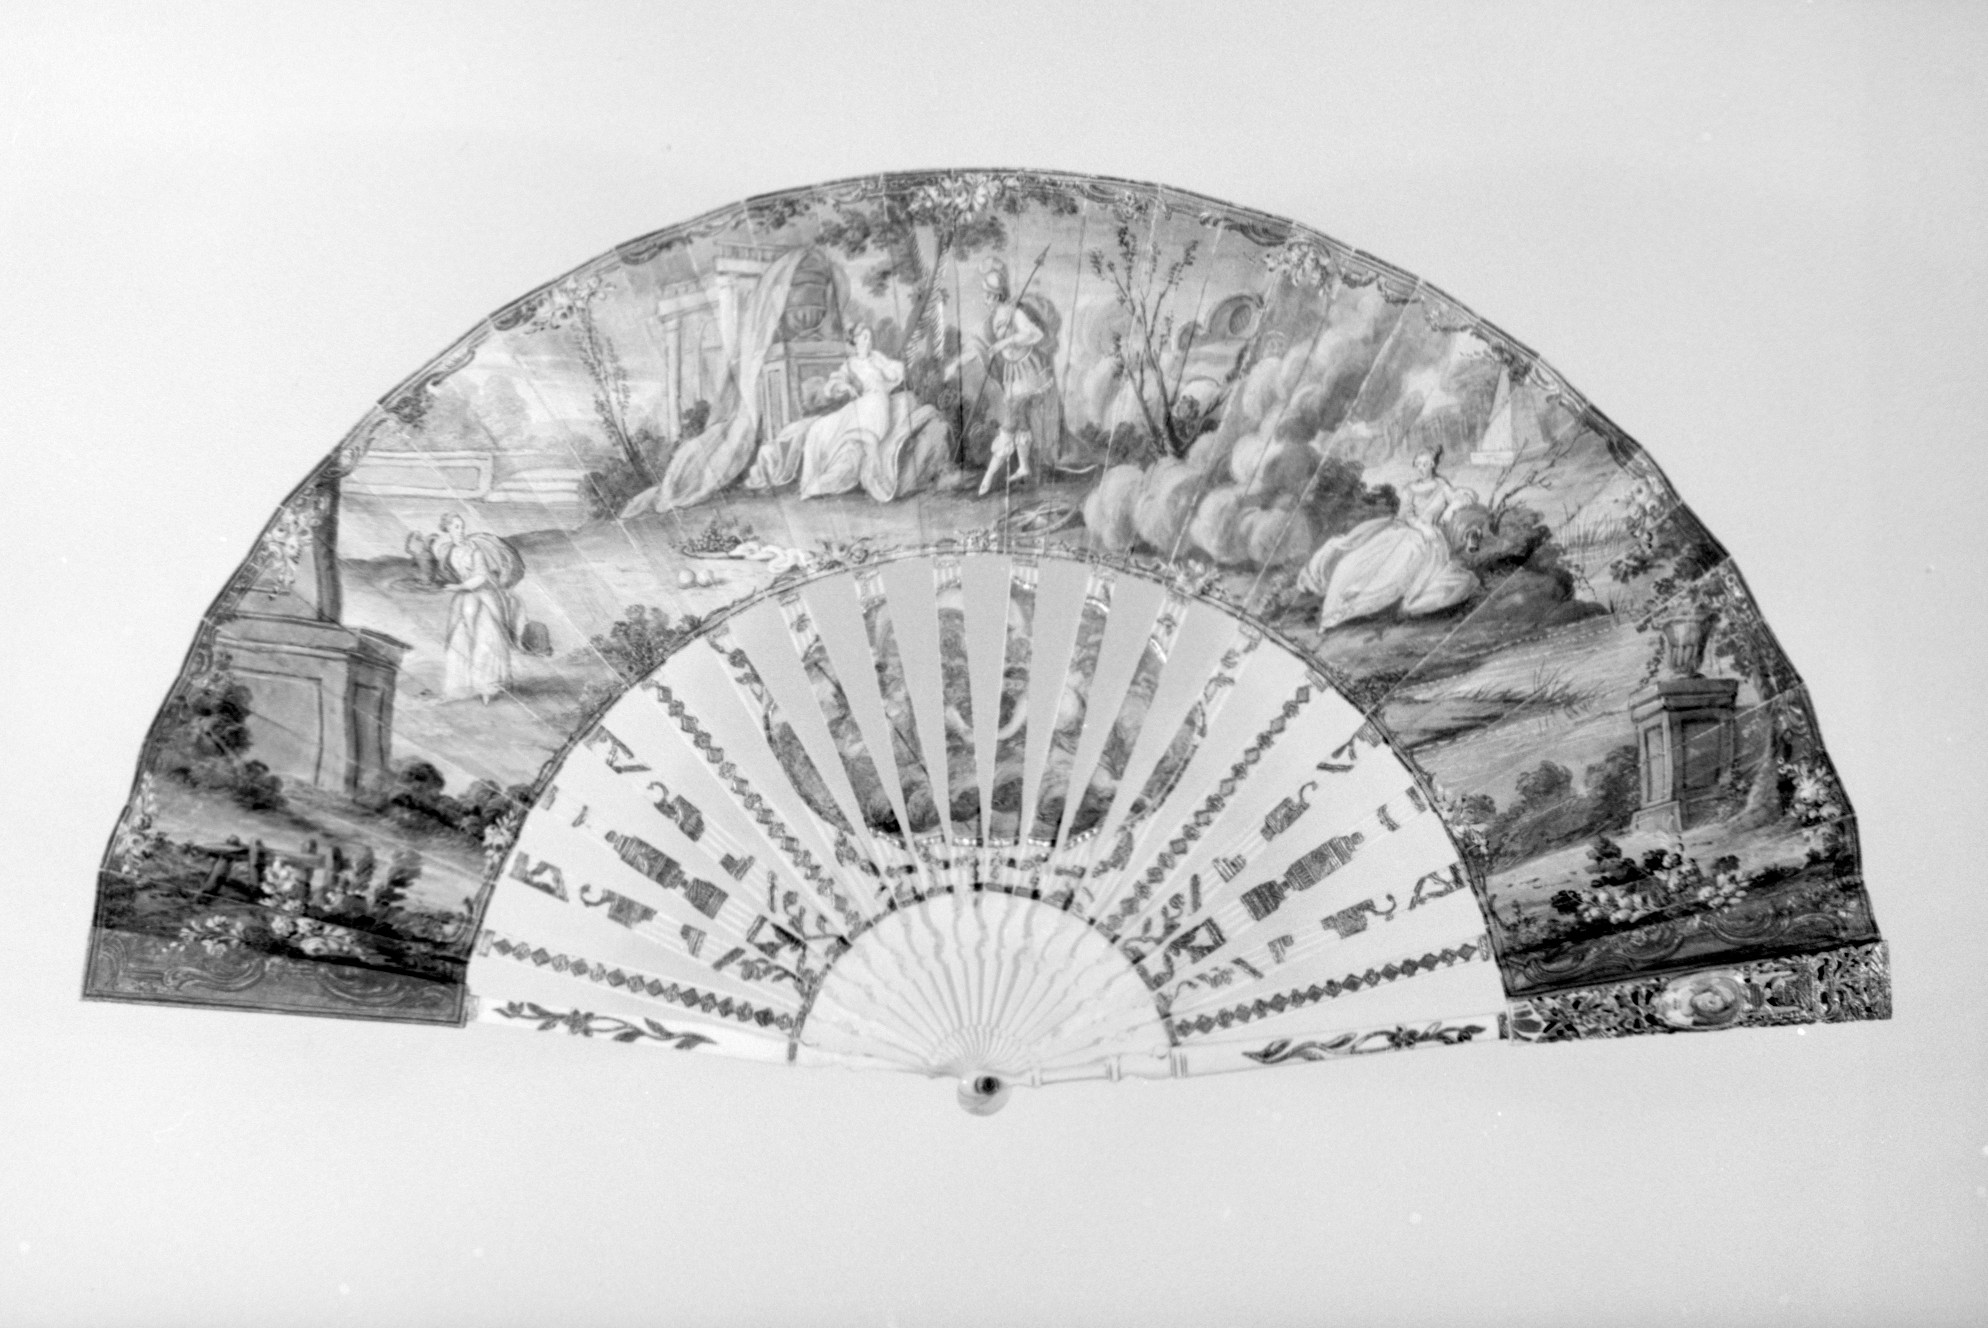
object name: fan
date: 1701-1800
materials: glass, ivory, paper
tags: soldiers,men,women